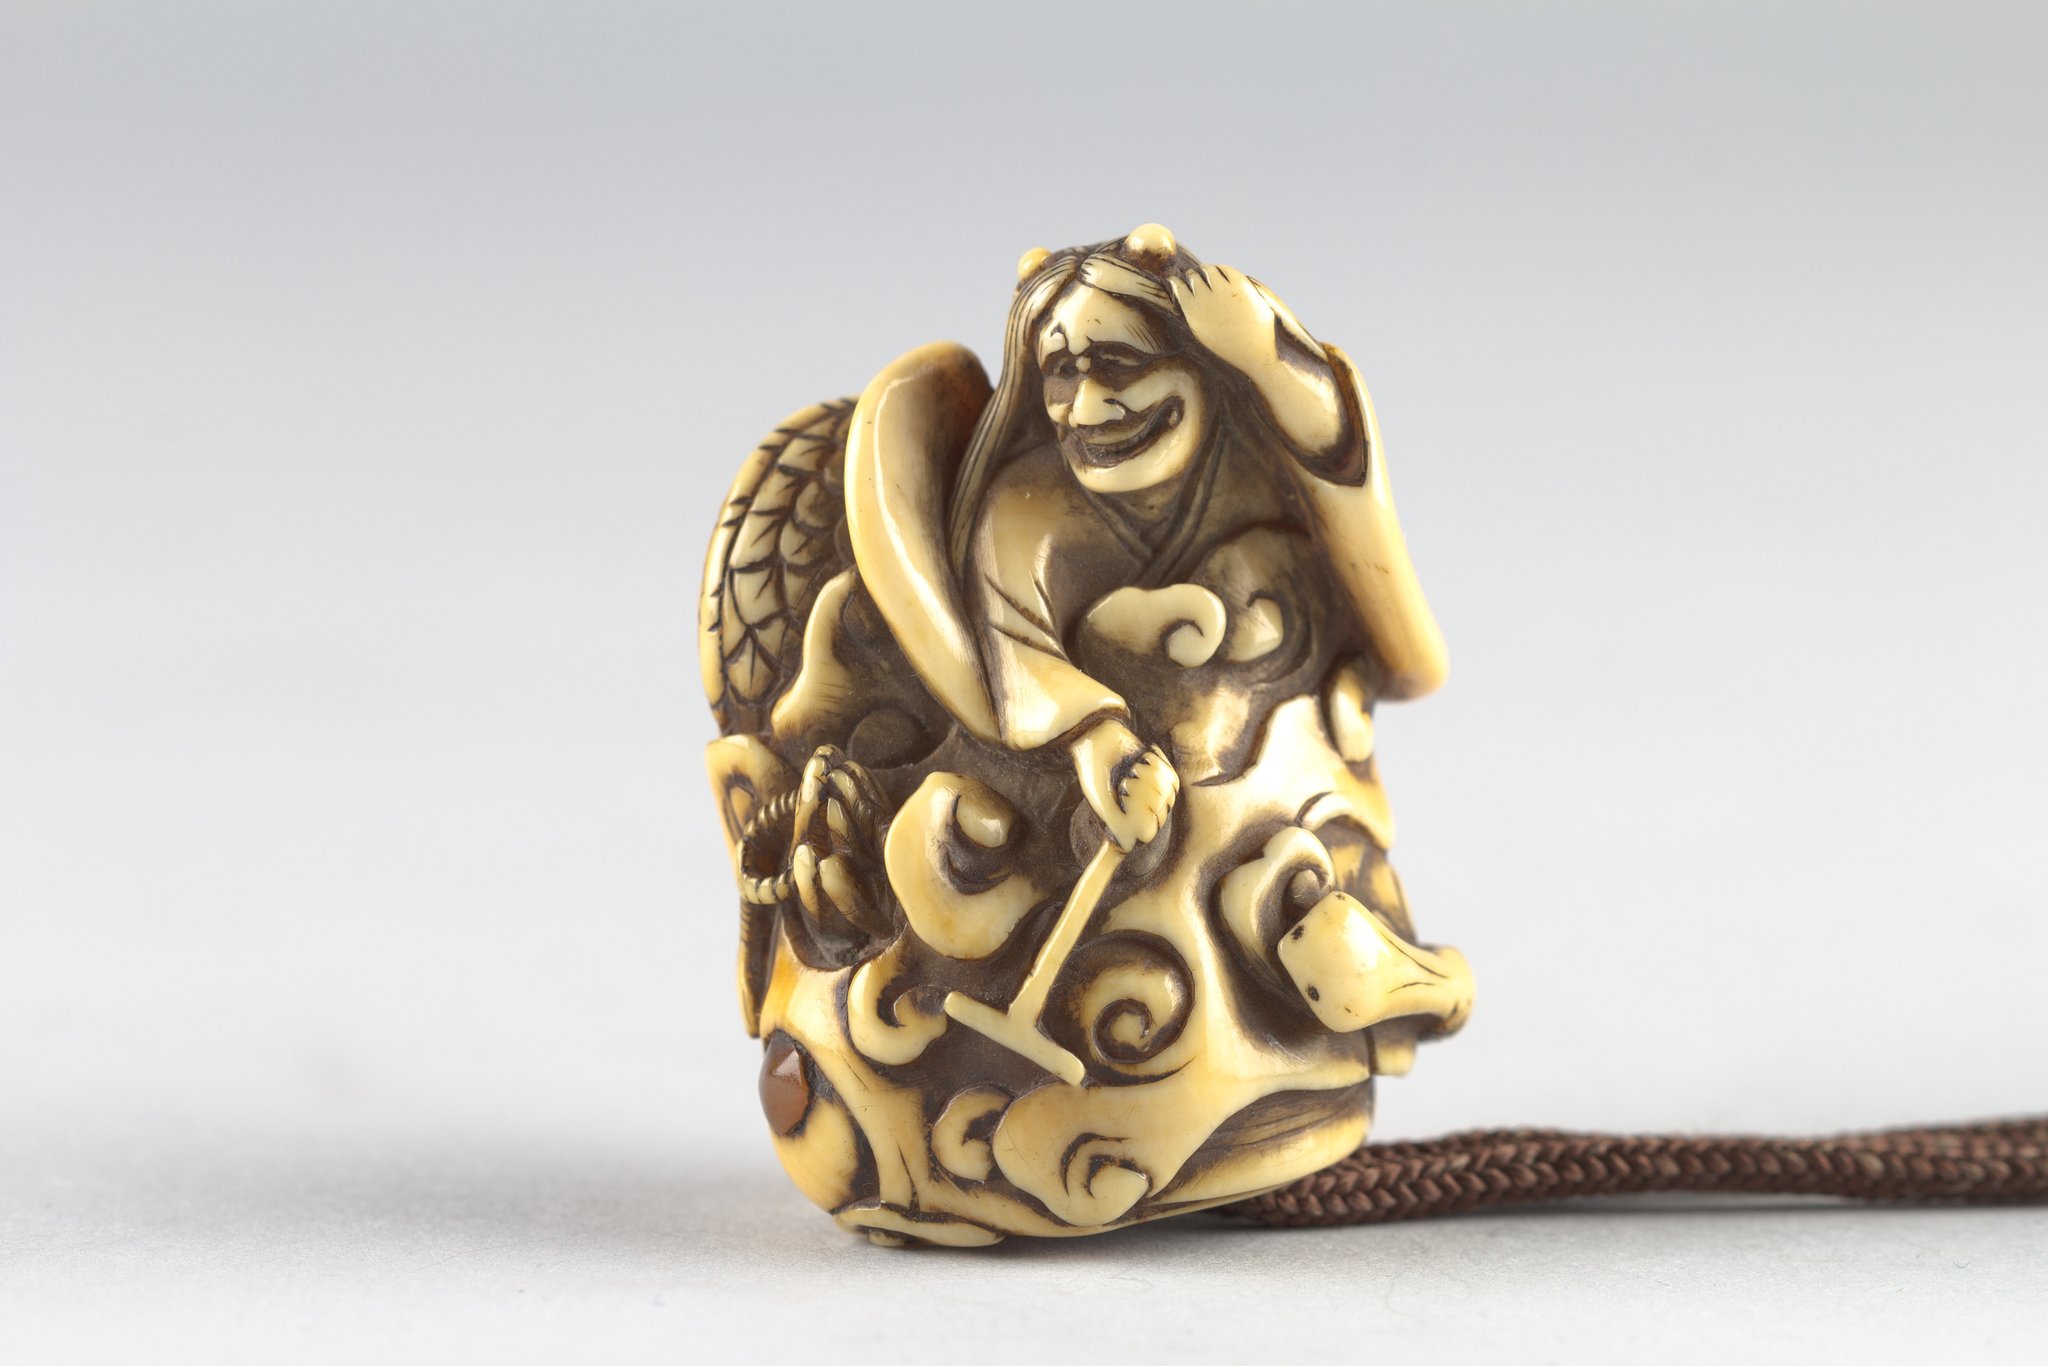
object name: netsuke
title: Netsuke in the Shape of a Demon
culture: japanese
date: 1801-1900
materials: ivory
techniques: carving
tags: demons